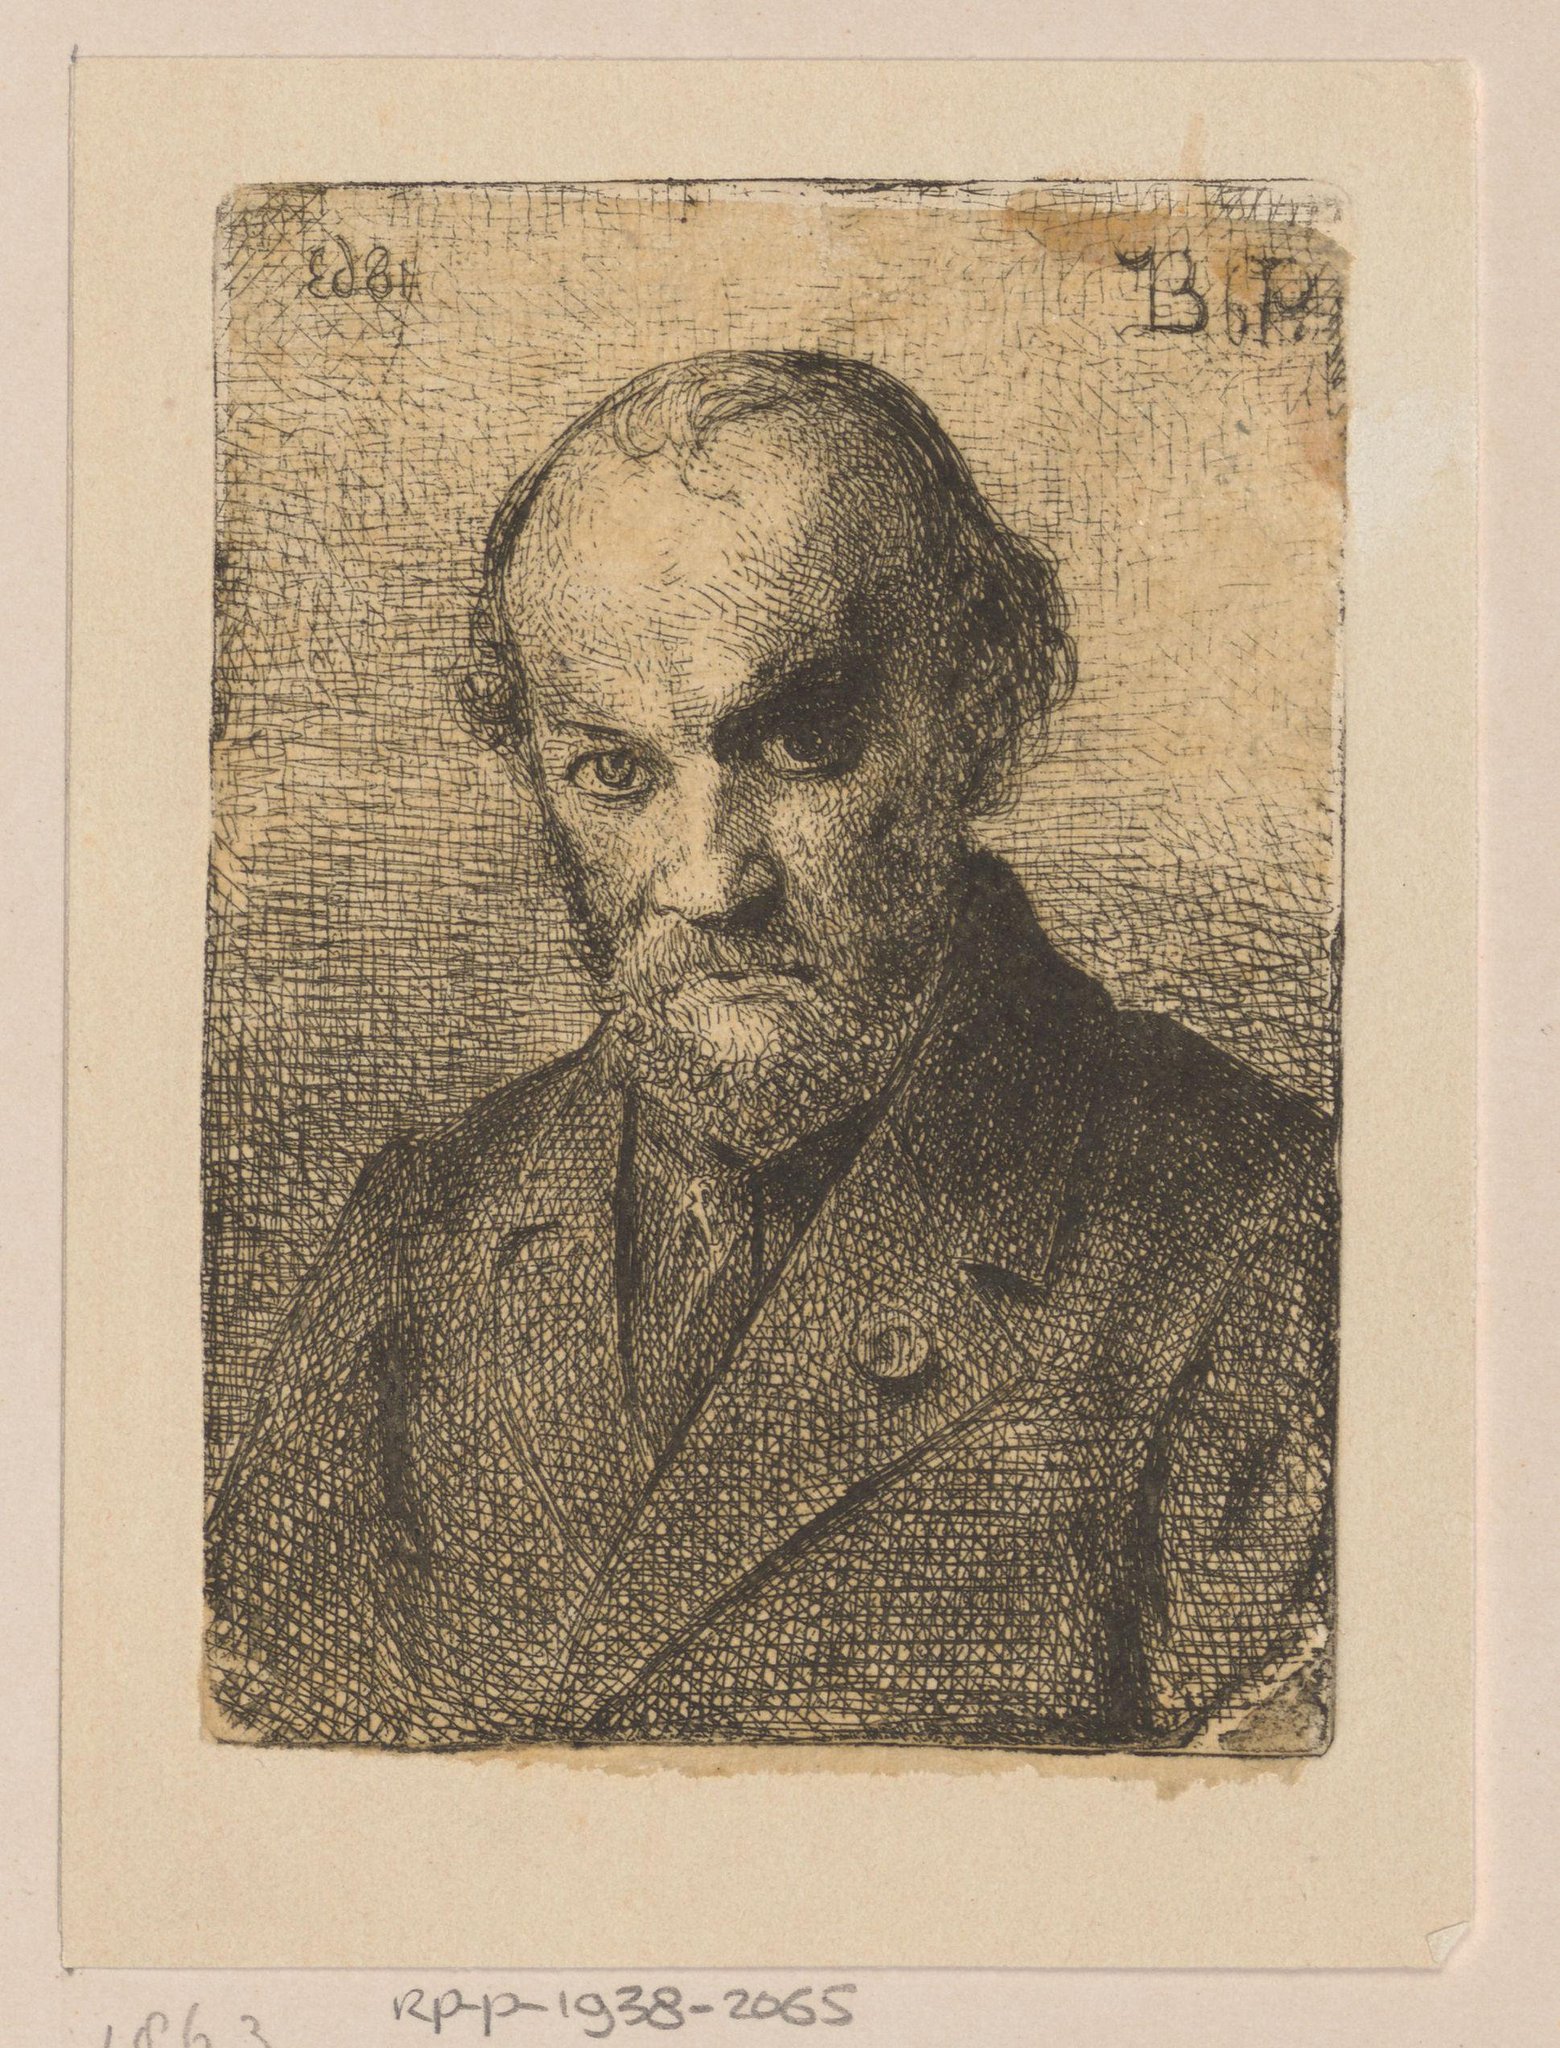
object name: print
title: Portret van Jan Weissenbruch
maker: bastiaan de poorter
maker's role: painter, print maker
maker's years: 1813-1880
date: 1863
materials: paper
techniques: etching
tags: painter, jan weissenbruch, historical persons, portrait, self-portrait of painter, portrait, self-portrait of graphic artist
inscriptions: collector's mark: Lugt 2760